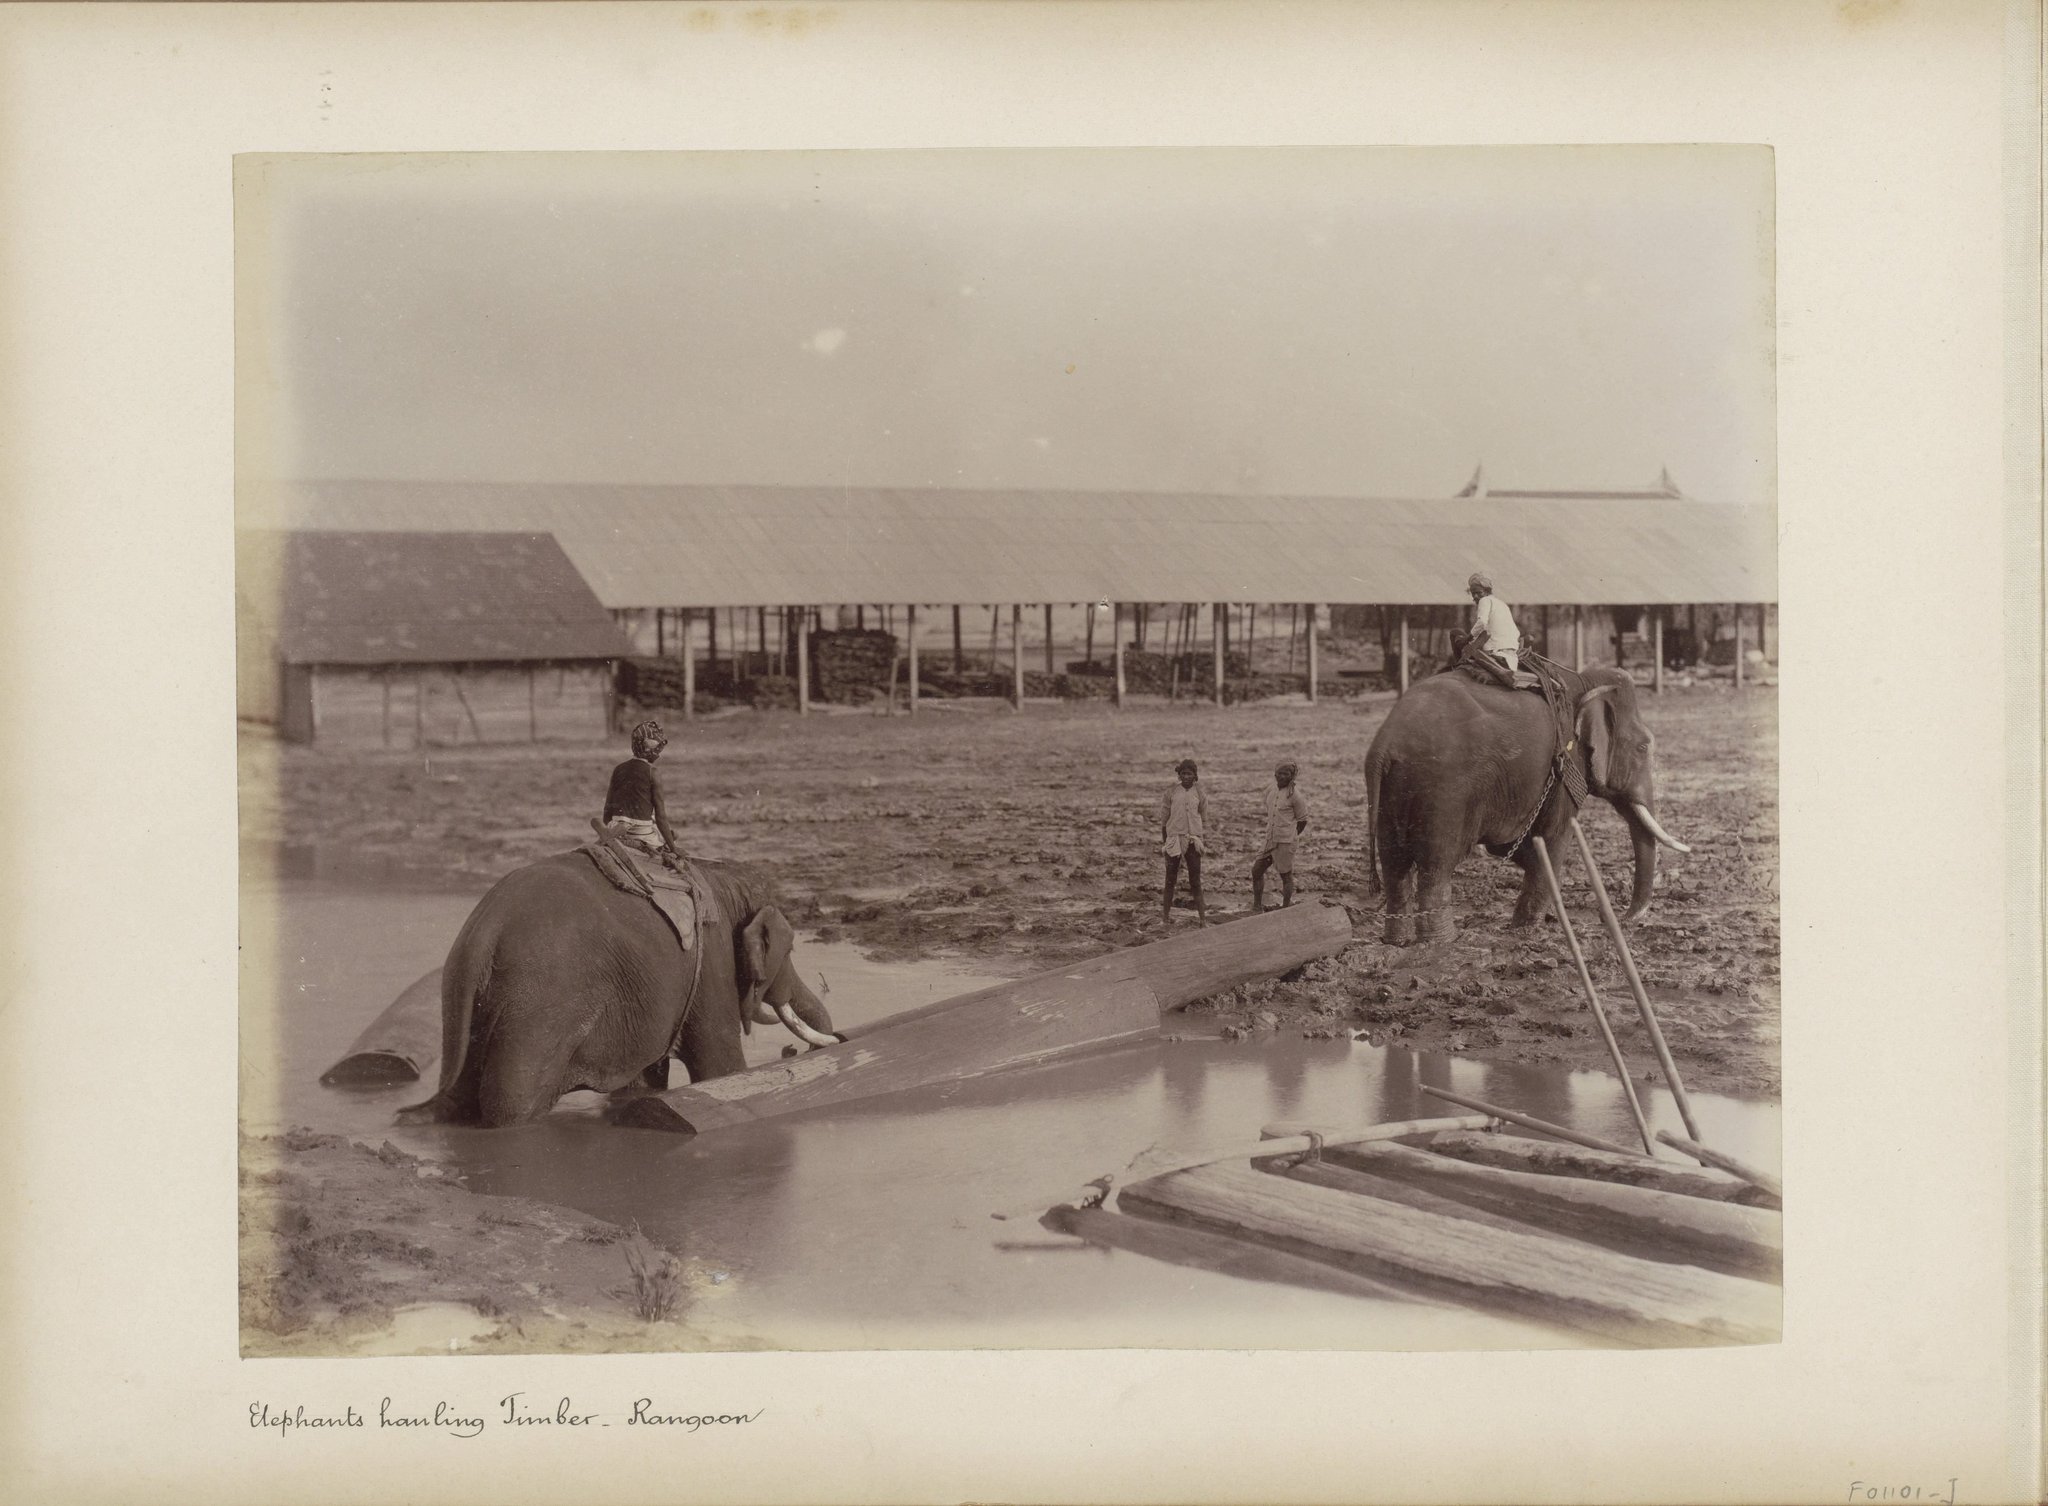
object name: photograph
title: Elephants working in timber extraction of Yangon, Myanmar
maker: philip adolphe klier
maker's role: fotograaf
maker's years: 1845-1911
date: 1885-1886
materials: cardboard, paper, photographic support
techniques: albumen print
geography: yangon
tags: transport of timber, timber-trailer, trunked animals: elephant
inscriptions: caption: ‘Elephants hauling Timber - Rangoon’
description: Onderdeel van Reisalbum met foto's van bezienswaardigheden in Birma.